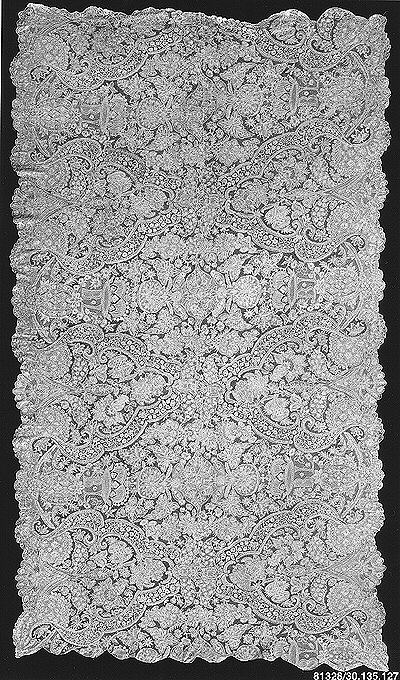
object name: flounce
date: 1701-1800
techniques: lace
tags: flowers